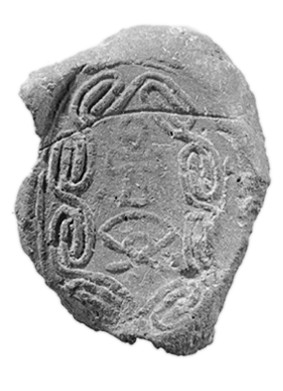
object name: sealing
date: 2030-1640 BCE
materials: clay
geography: egypt